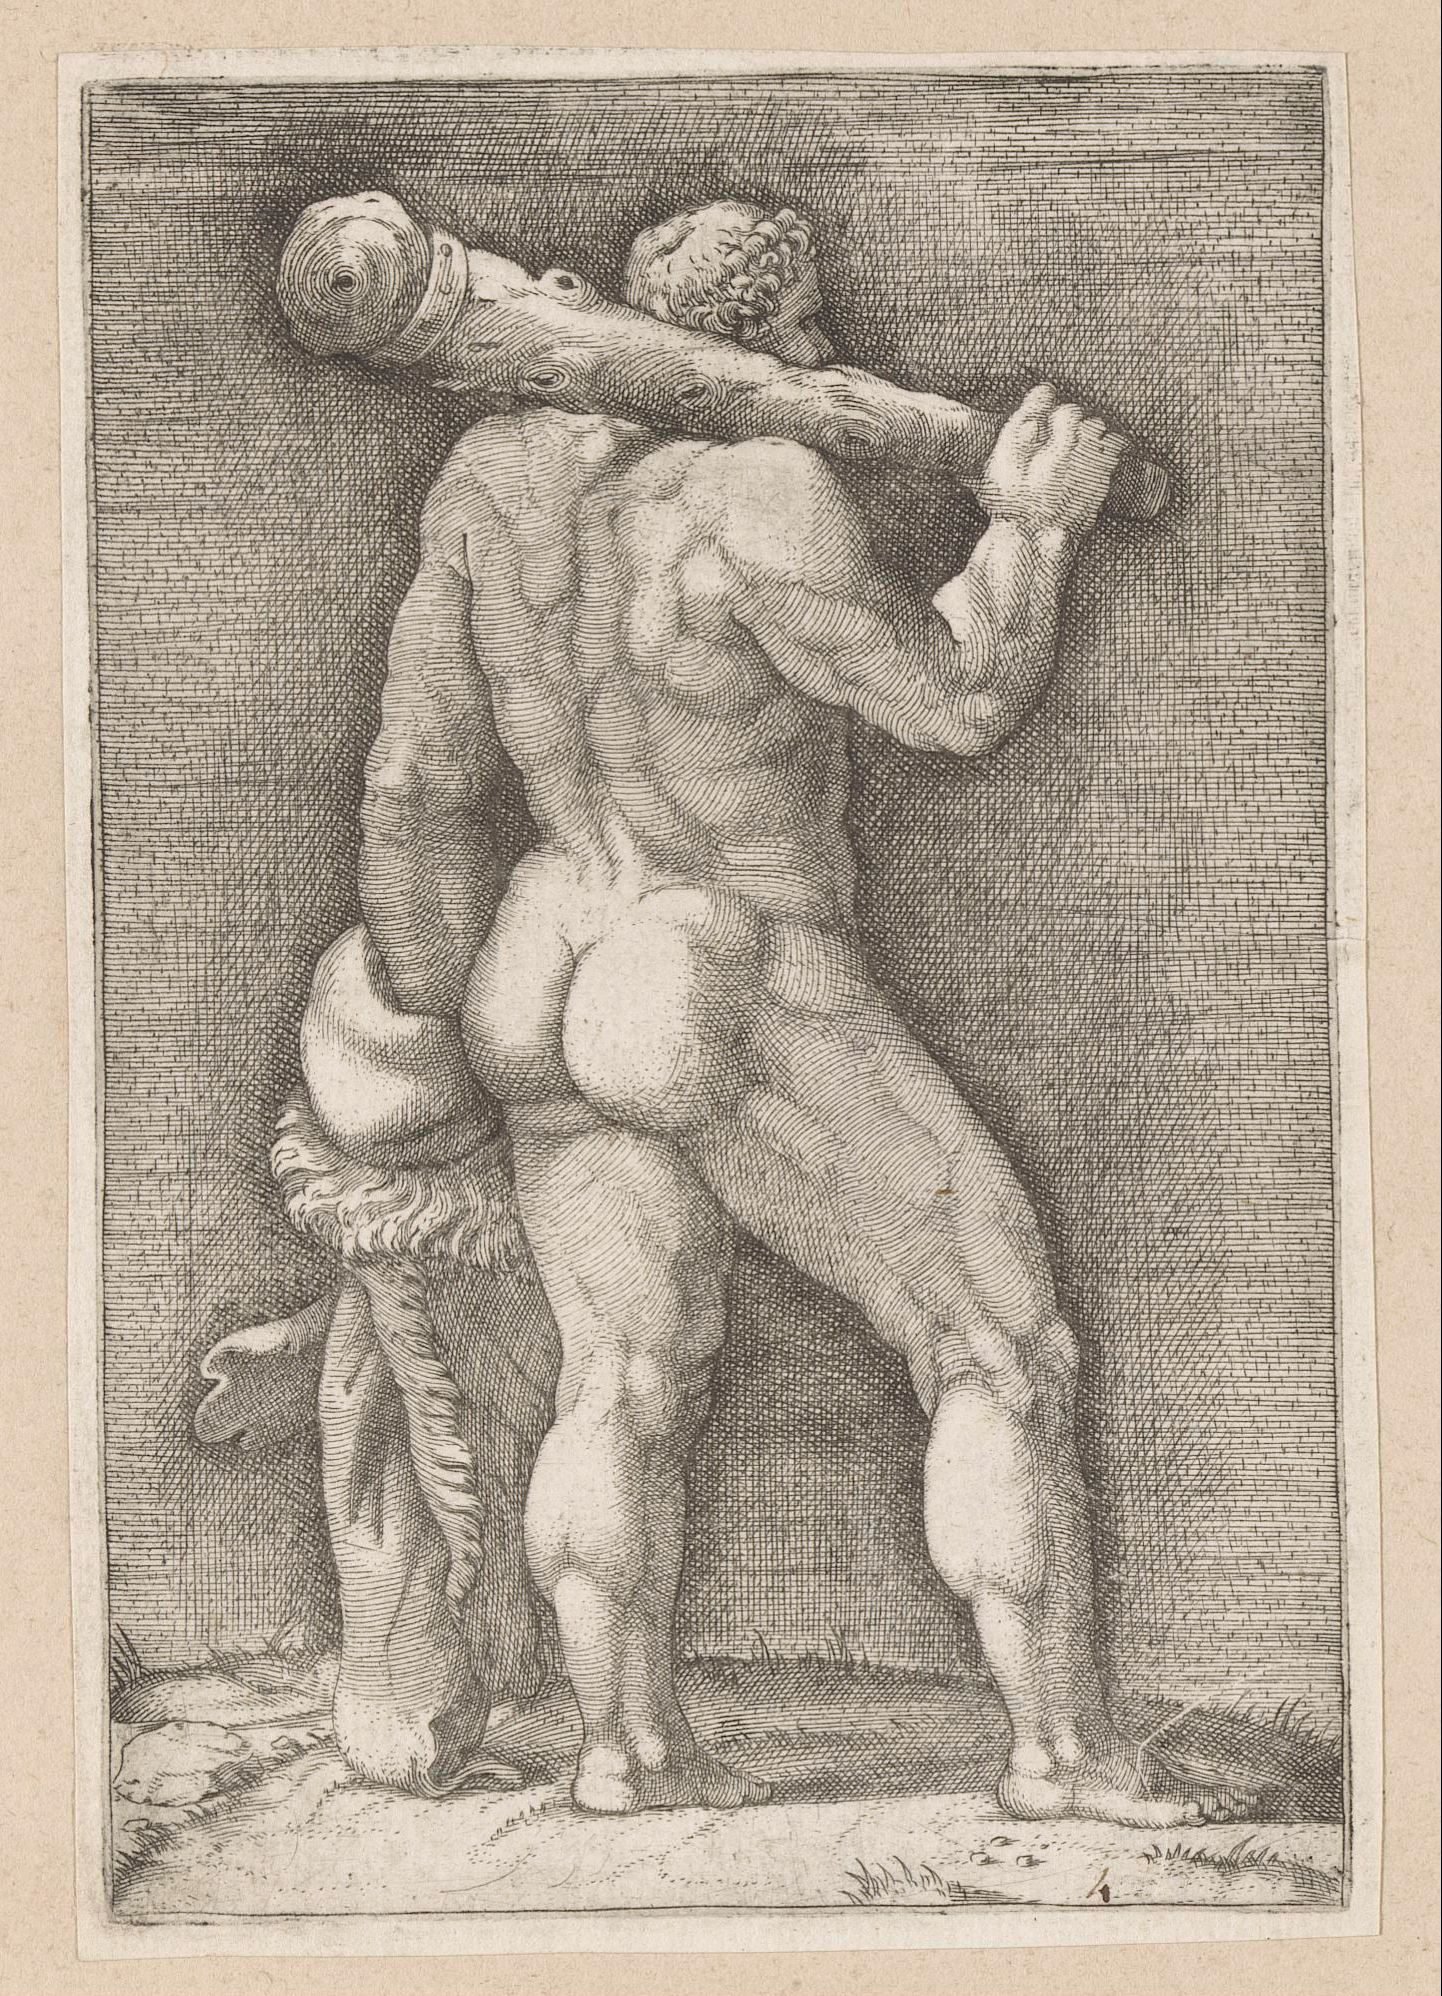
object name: print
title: Hercules op de rug gezien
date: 1540-1585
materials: paper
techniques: engraving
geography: italy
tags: (story of) hercules (heracles), attributes of hercules (with name)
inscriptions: collector's mark: ‘Hinloopen’, collector's mark: Lugt 11, collector's mark: Lugt 10, number: ‘4’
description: Hercules op de rug gezien met knots en leeuwenhuid.